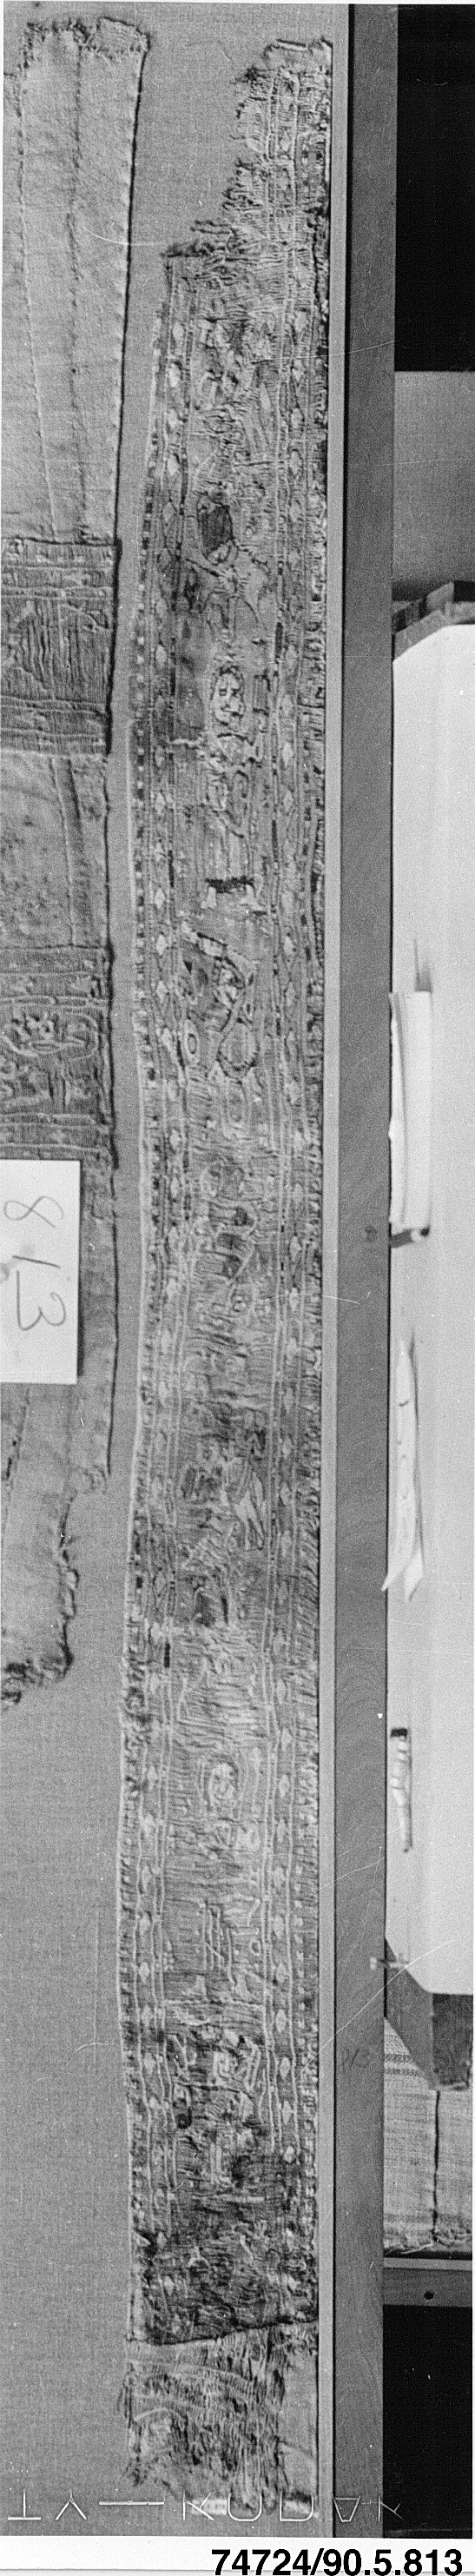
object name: textile fragment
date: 501-700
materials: linen, wool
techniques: weave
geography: egypt